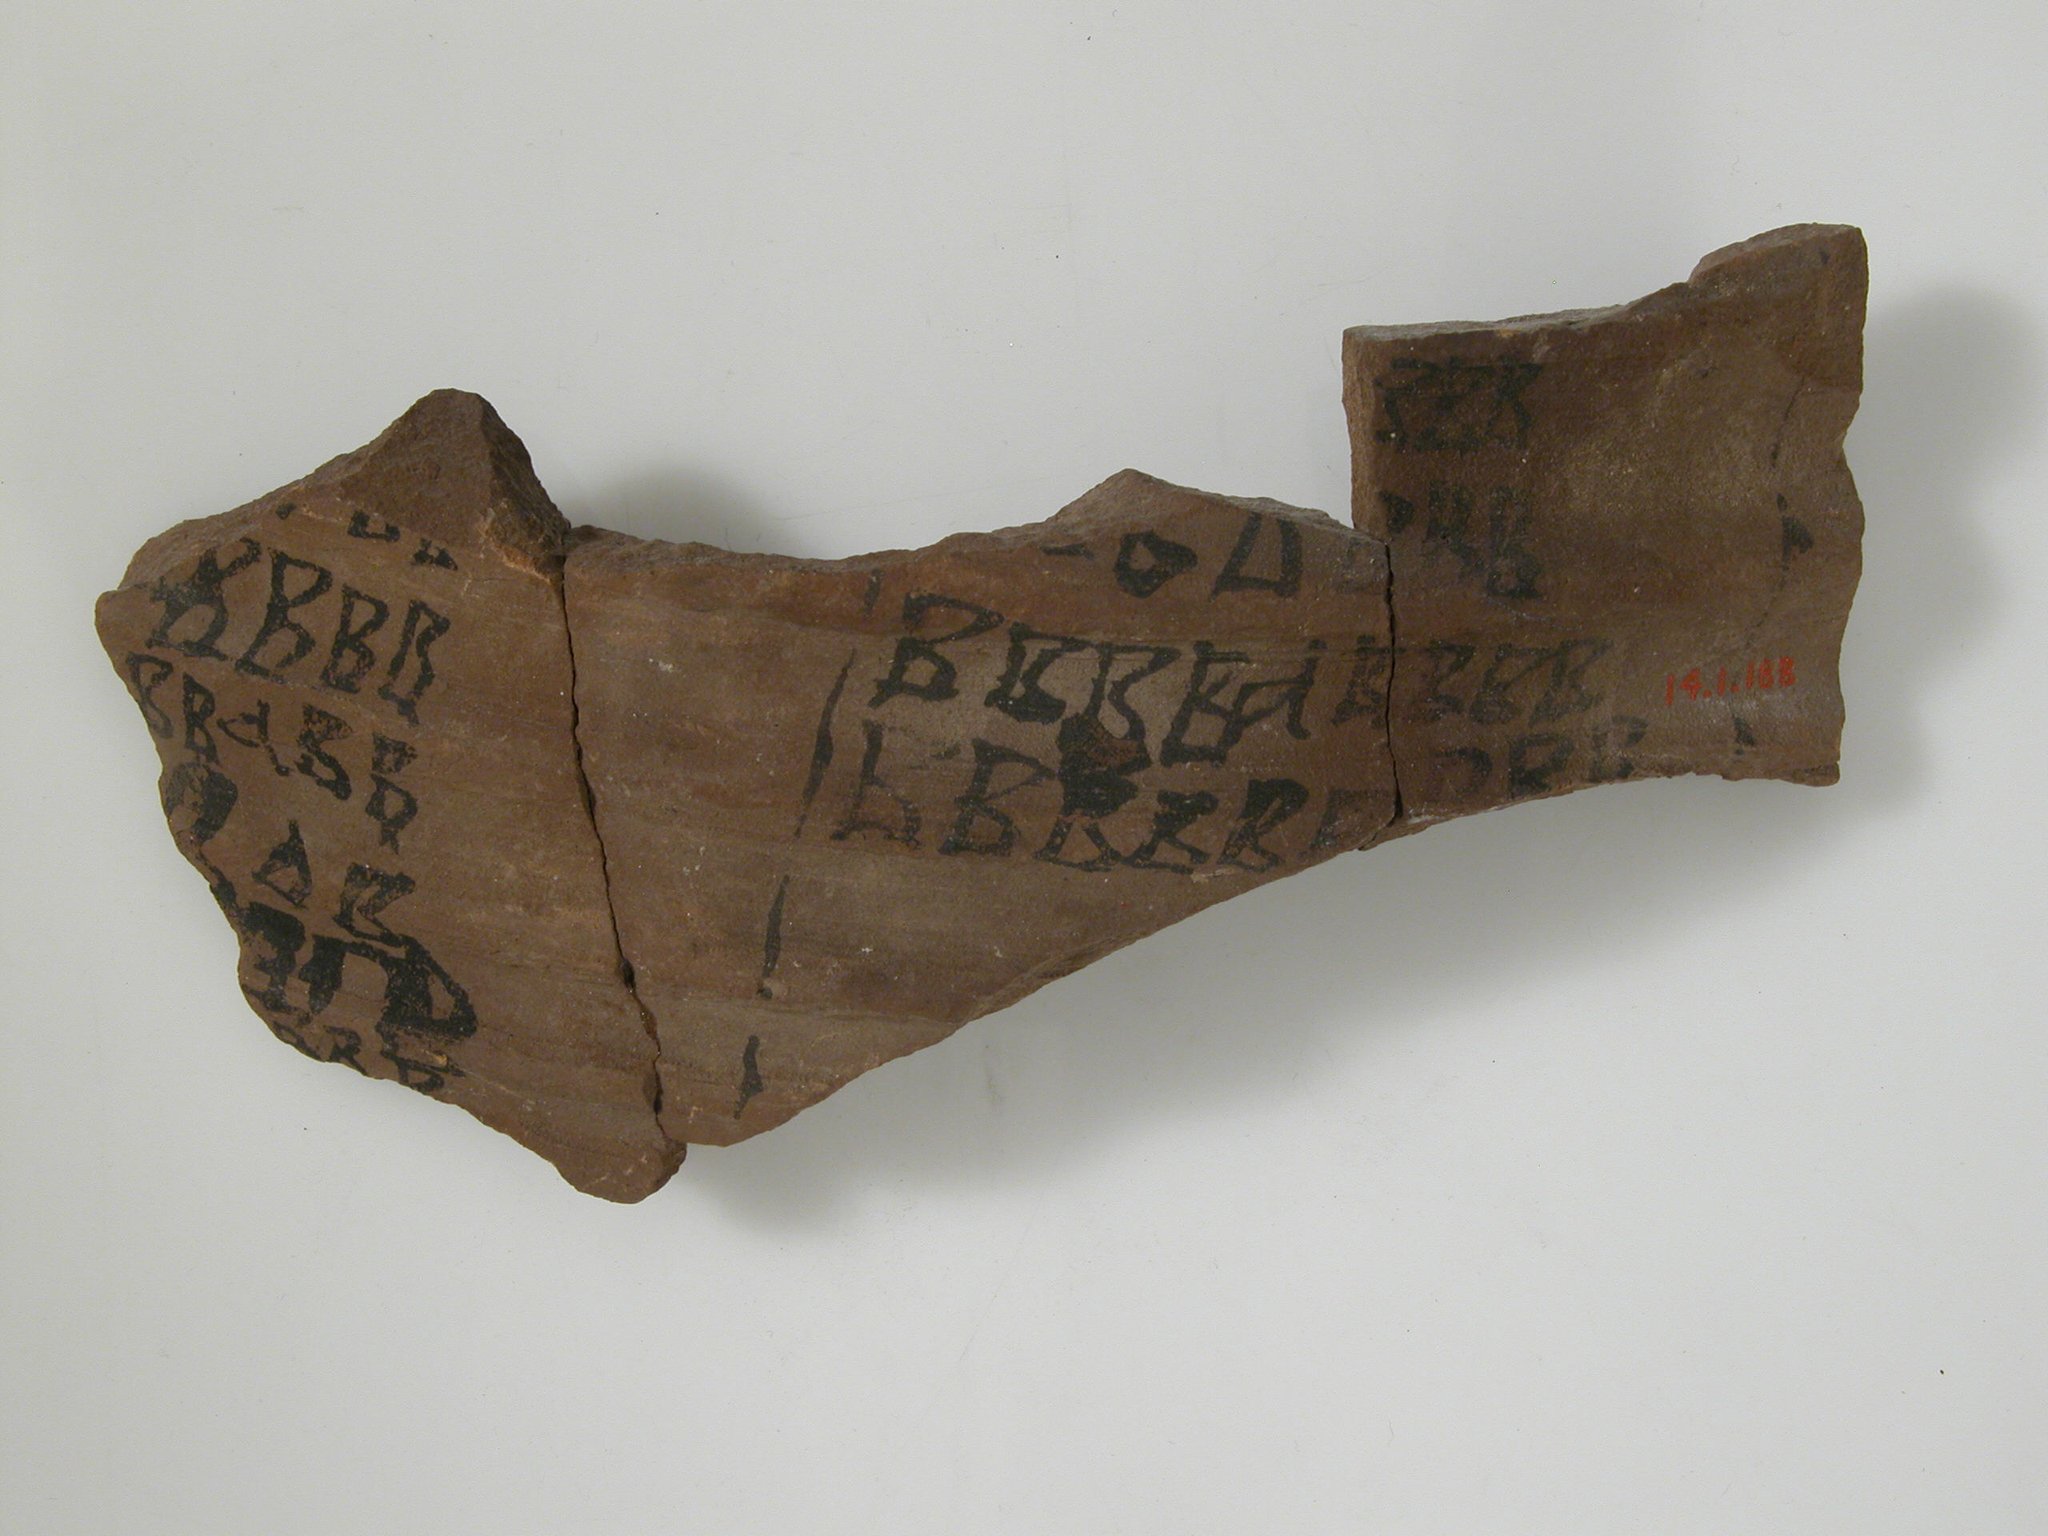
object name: ostrakon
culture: coptic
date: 580-640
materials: ink, pottery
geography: egypt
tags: coptic,documents